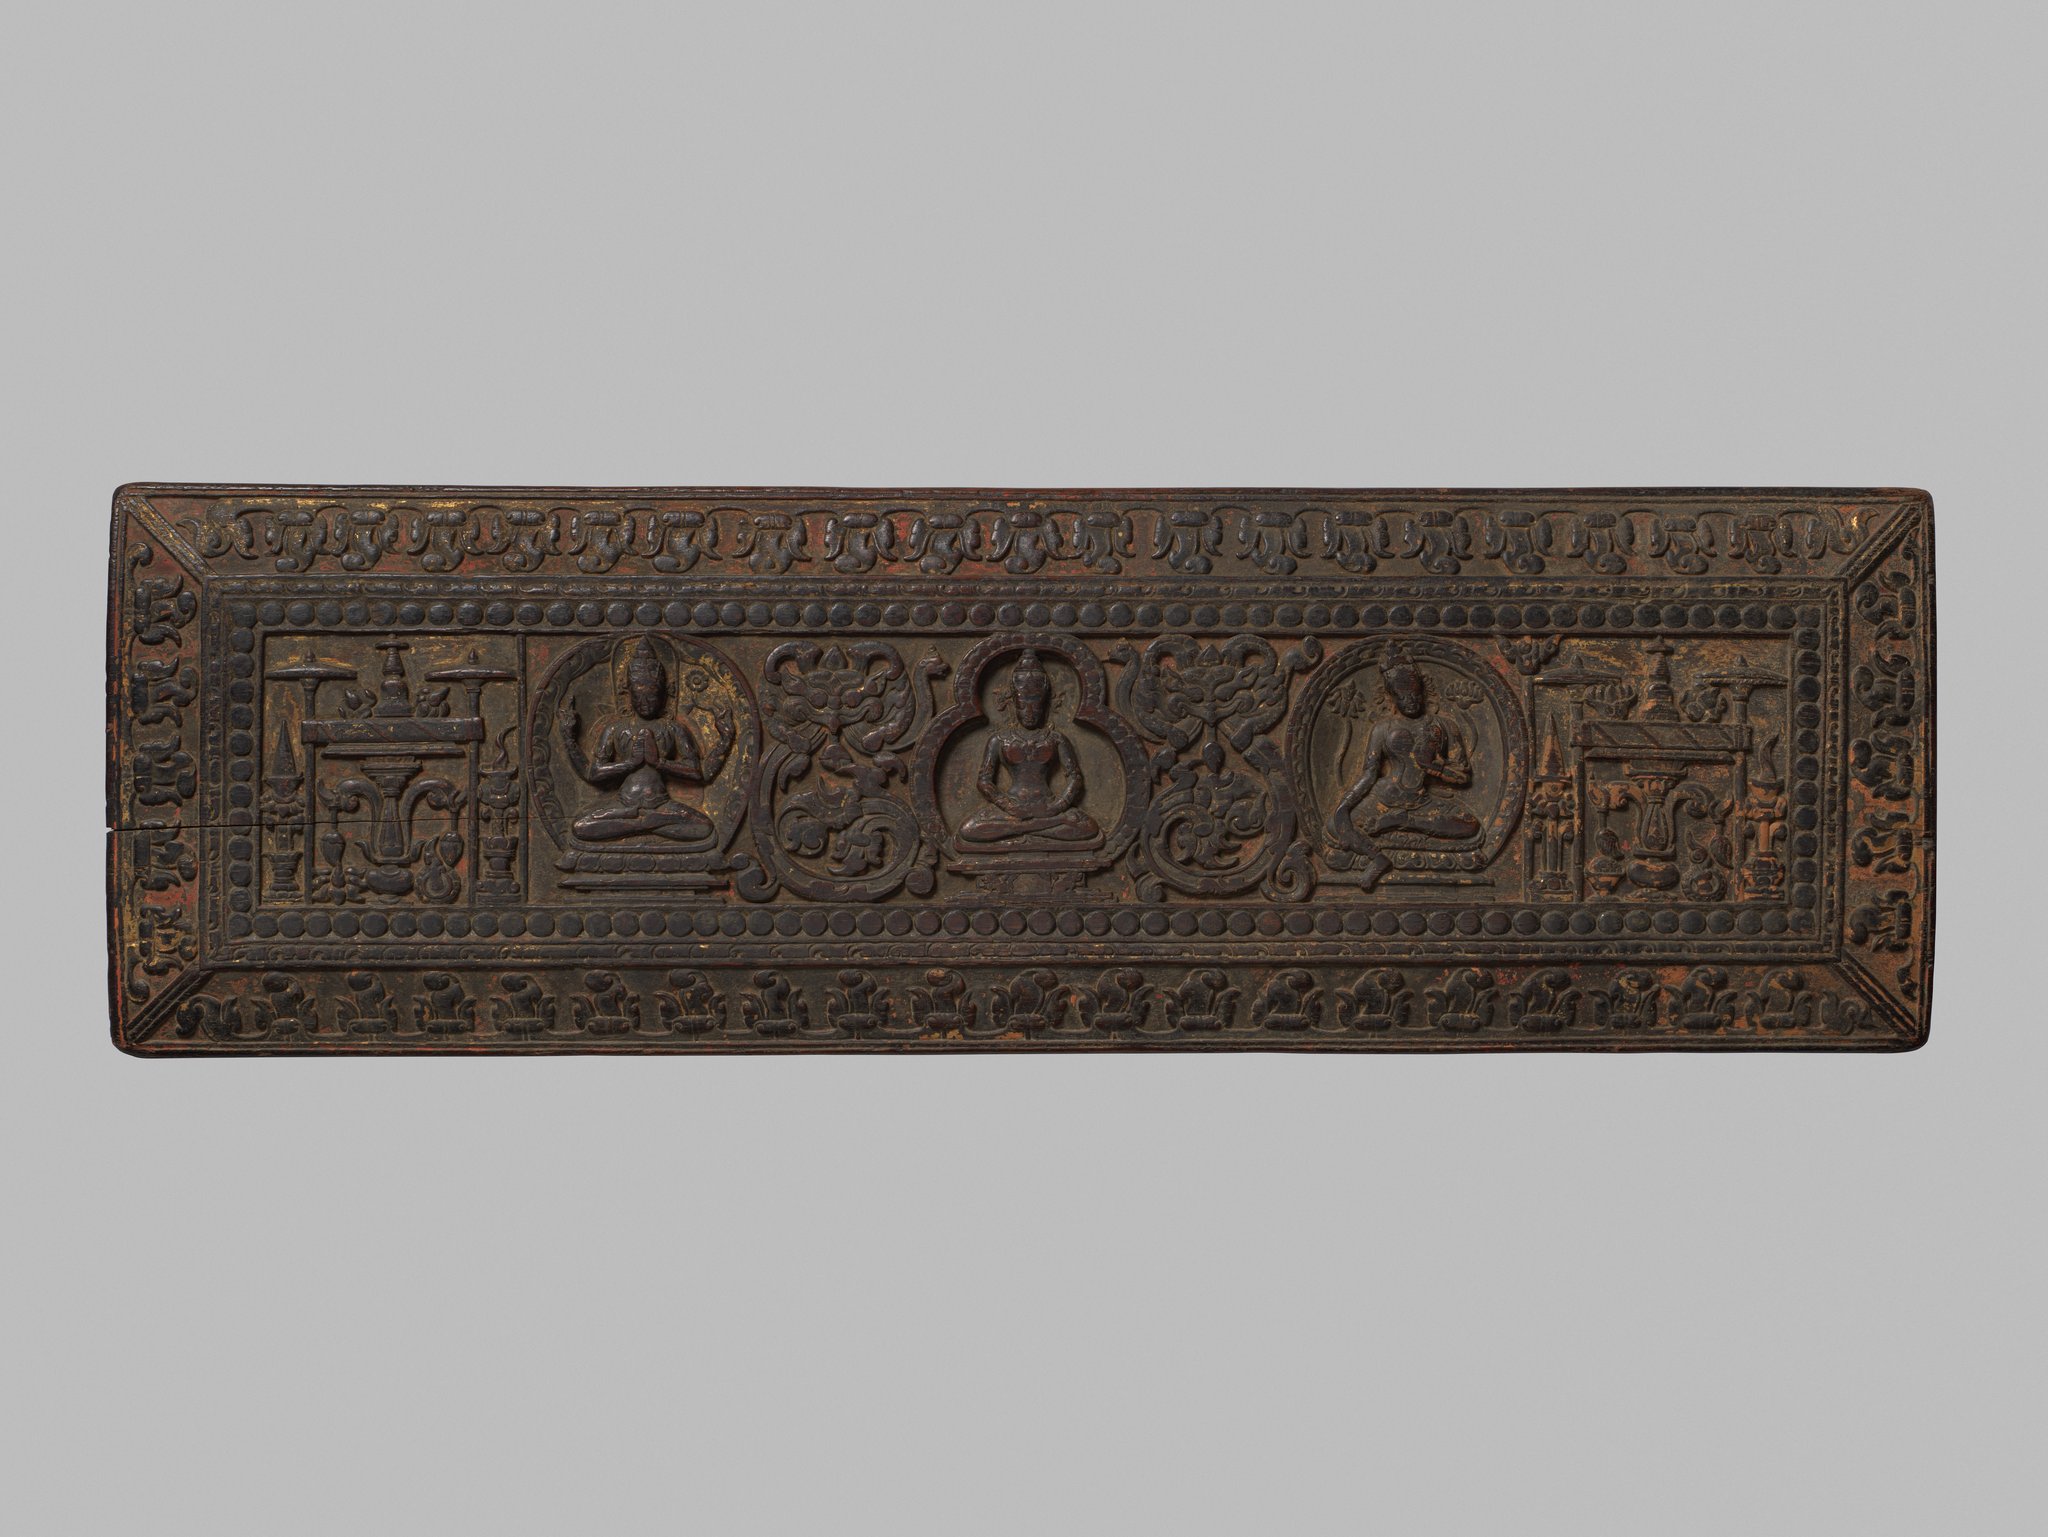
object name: manuscript cover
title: Manuscript Cover with Prajnaparamita Attended by Sadakshari Lokeshvara and a Tara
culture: tibetan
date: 1301-1500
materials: wood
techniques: gilding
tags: buddhism,goddess